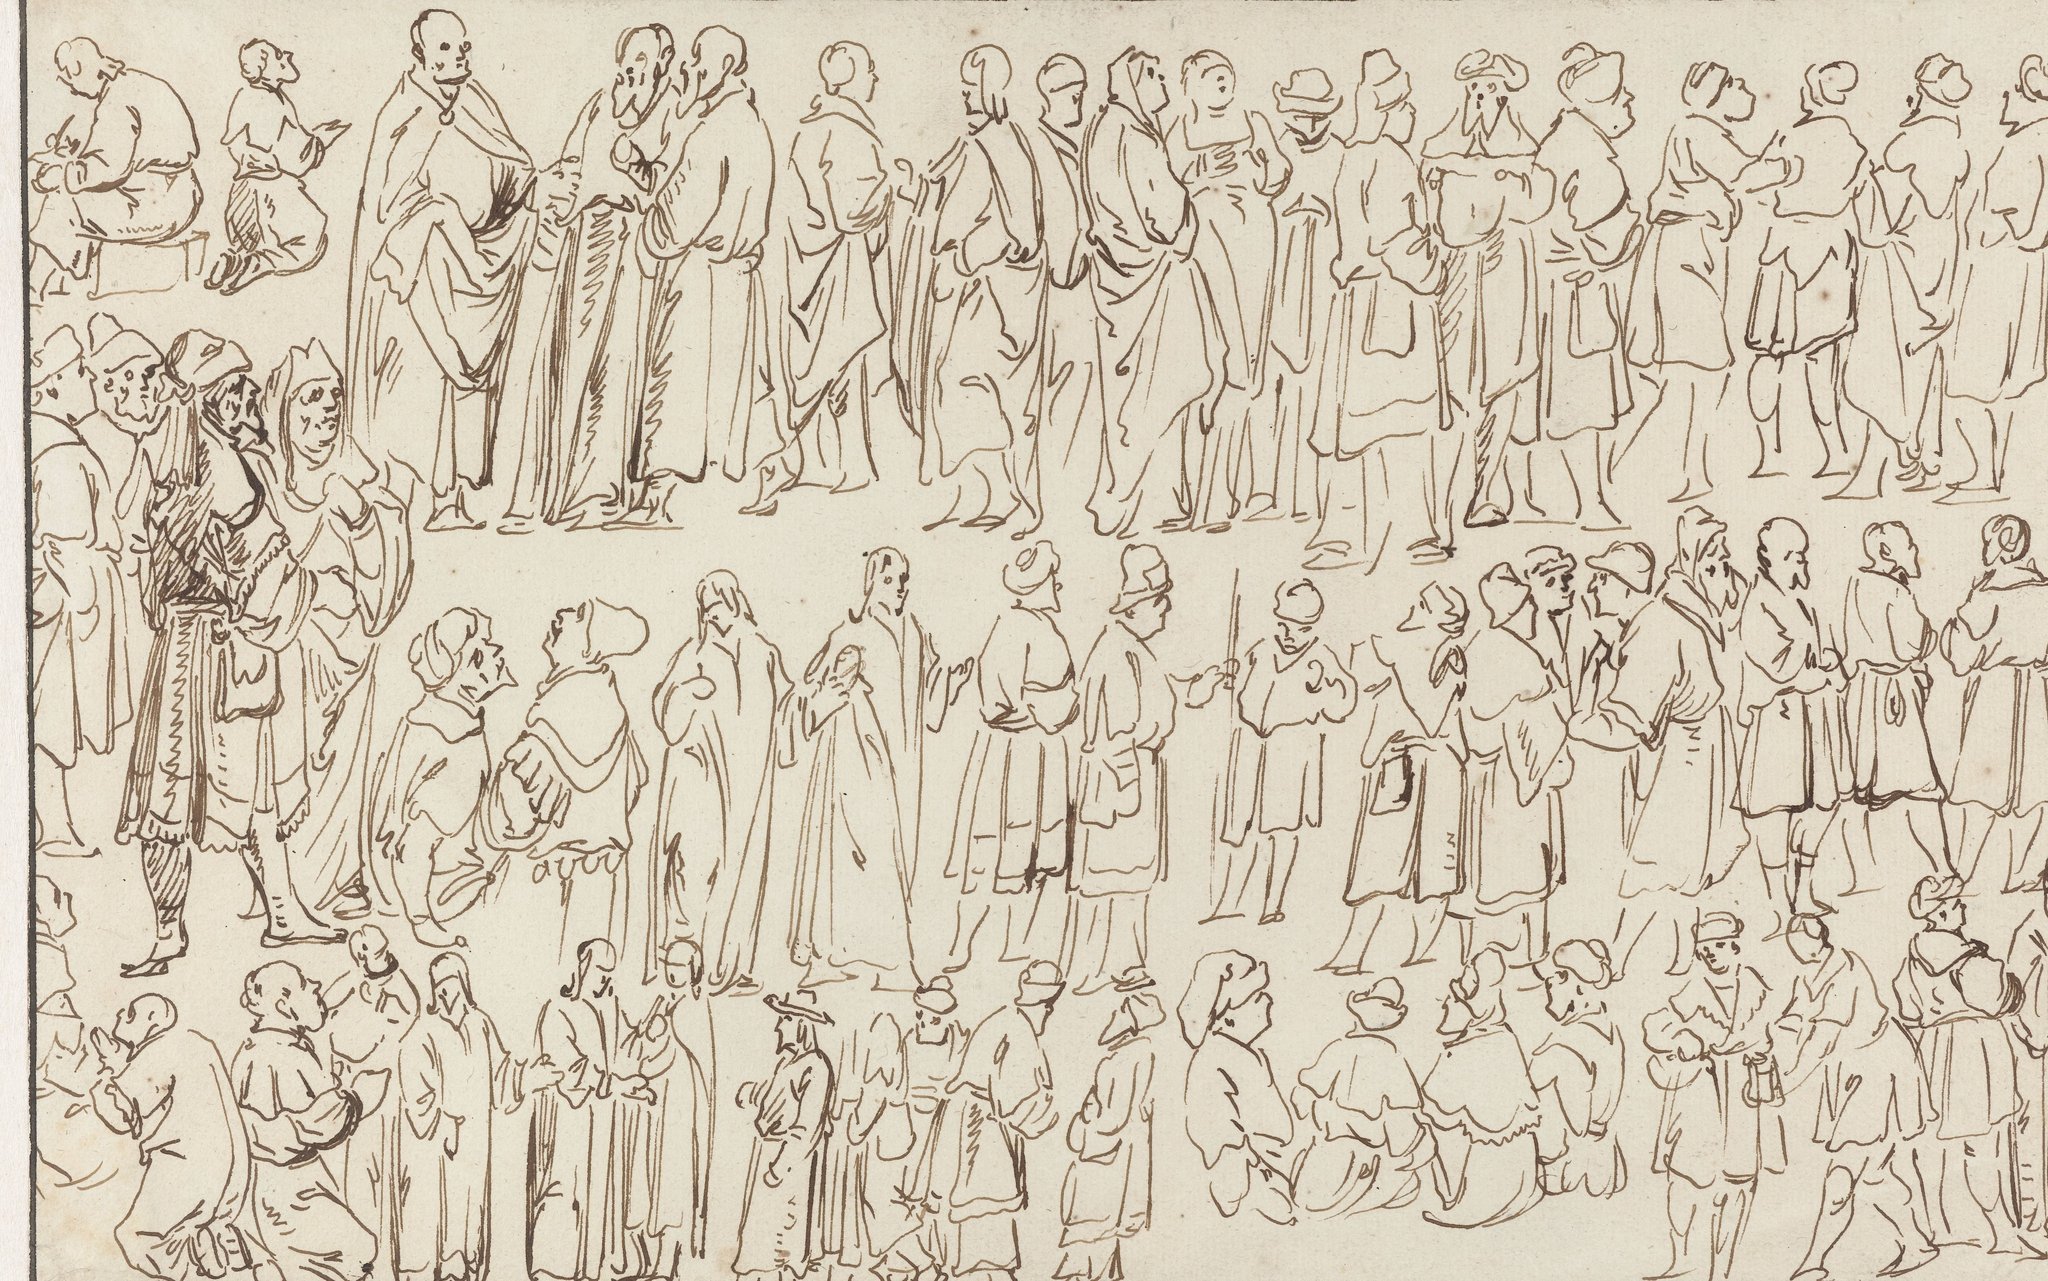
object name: drawing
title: Studieblad met drie rijen figuren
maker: pieter jansz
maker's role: draughtsman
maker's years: 1602-1672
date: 1630-1672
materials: ink, paper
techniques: pen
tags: sitting figure, standing figure (canon, proportions), male sex; man, kneeling on both knees